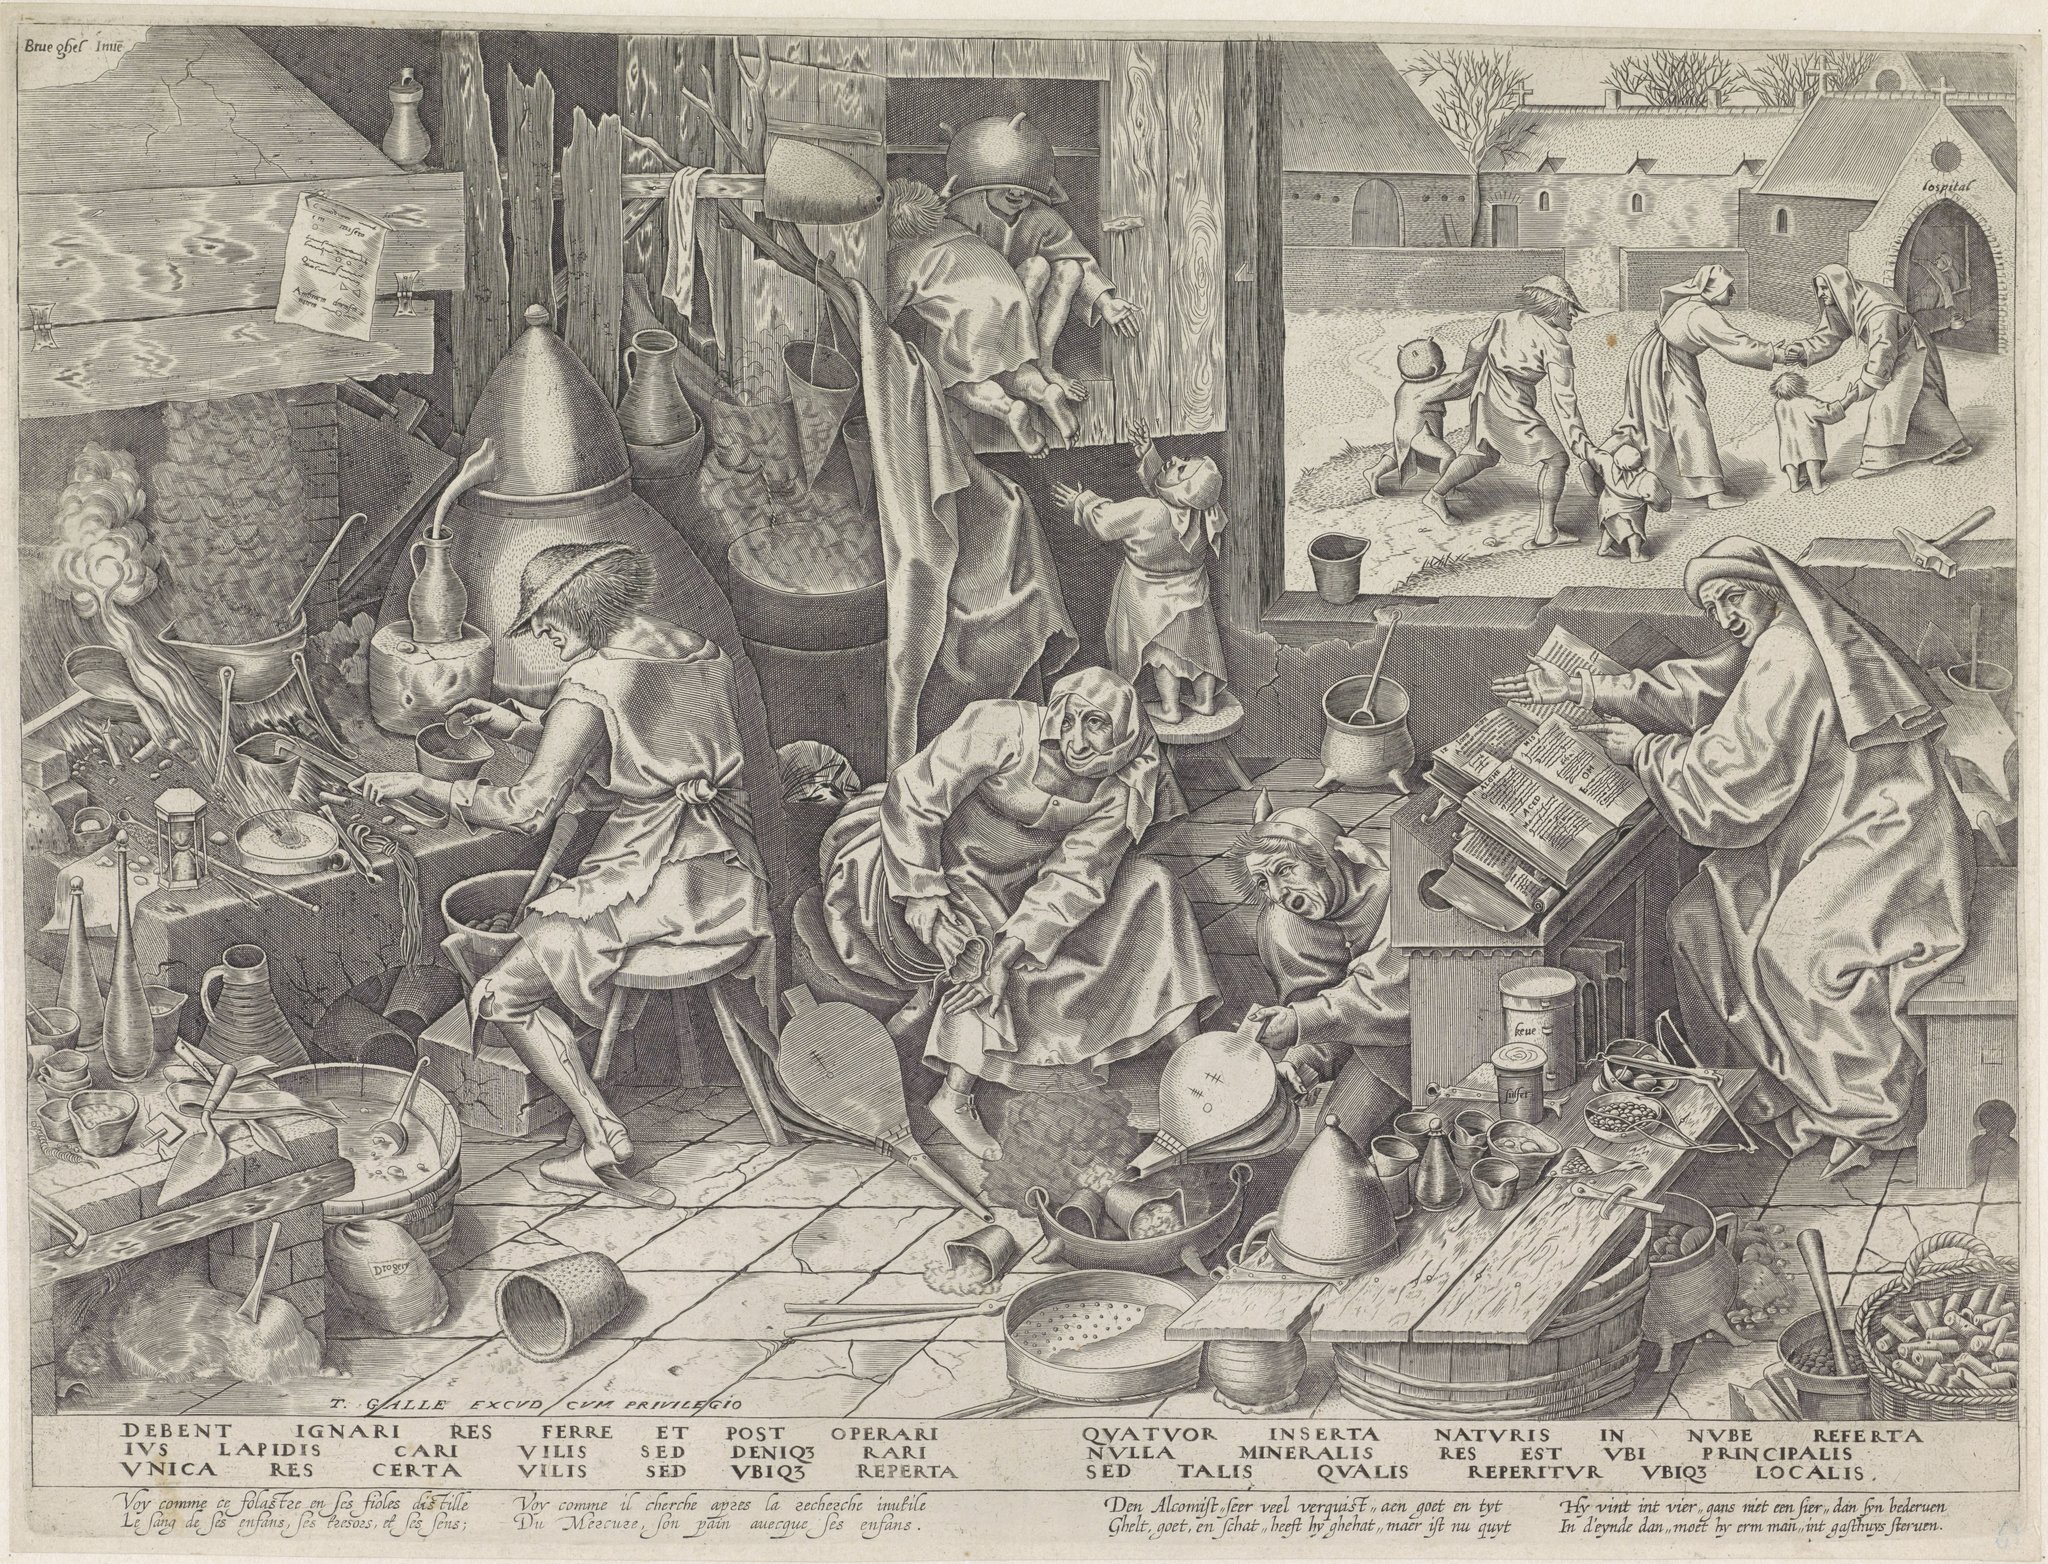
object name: print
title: Alchemist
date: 1556-1560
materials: paper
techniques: engraving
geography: antwerp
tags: book - mm - book open, fire, oven, furnace ~ interior of industrial structure, alchemist at work, bellows, the poor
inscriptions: collector's mark: Lugt 2228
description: Gezin van alchemisten aan het werk in een werkplaats. Links is een man bezig metalen te smelten op een fornuis en in het midden wordt met blaasbalgen een vuur opgestookt. Rechts een geleerde achter boeken. Drie kinderen ontsnappen aan de chaos door door een luik te kruipen. Op de achtergrond is te zien hoe het gezin in een gasthuis of ziekenhuis wordt opgevangen. Onder de voorstelling twee drieregelige verzen in het Latijn.